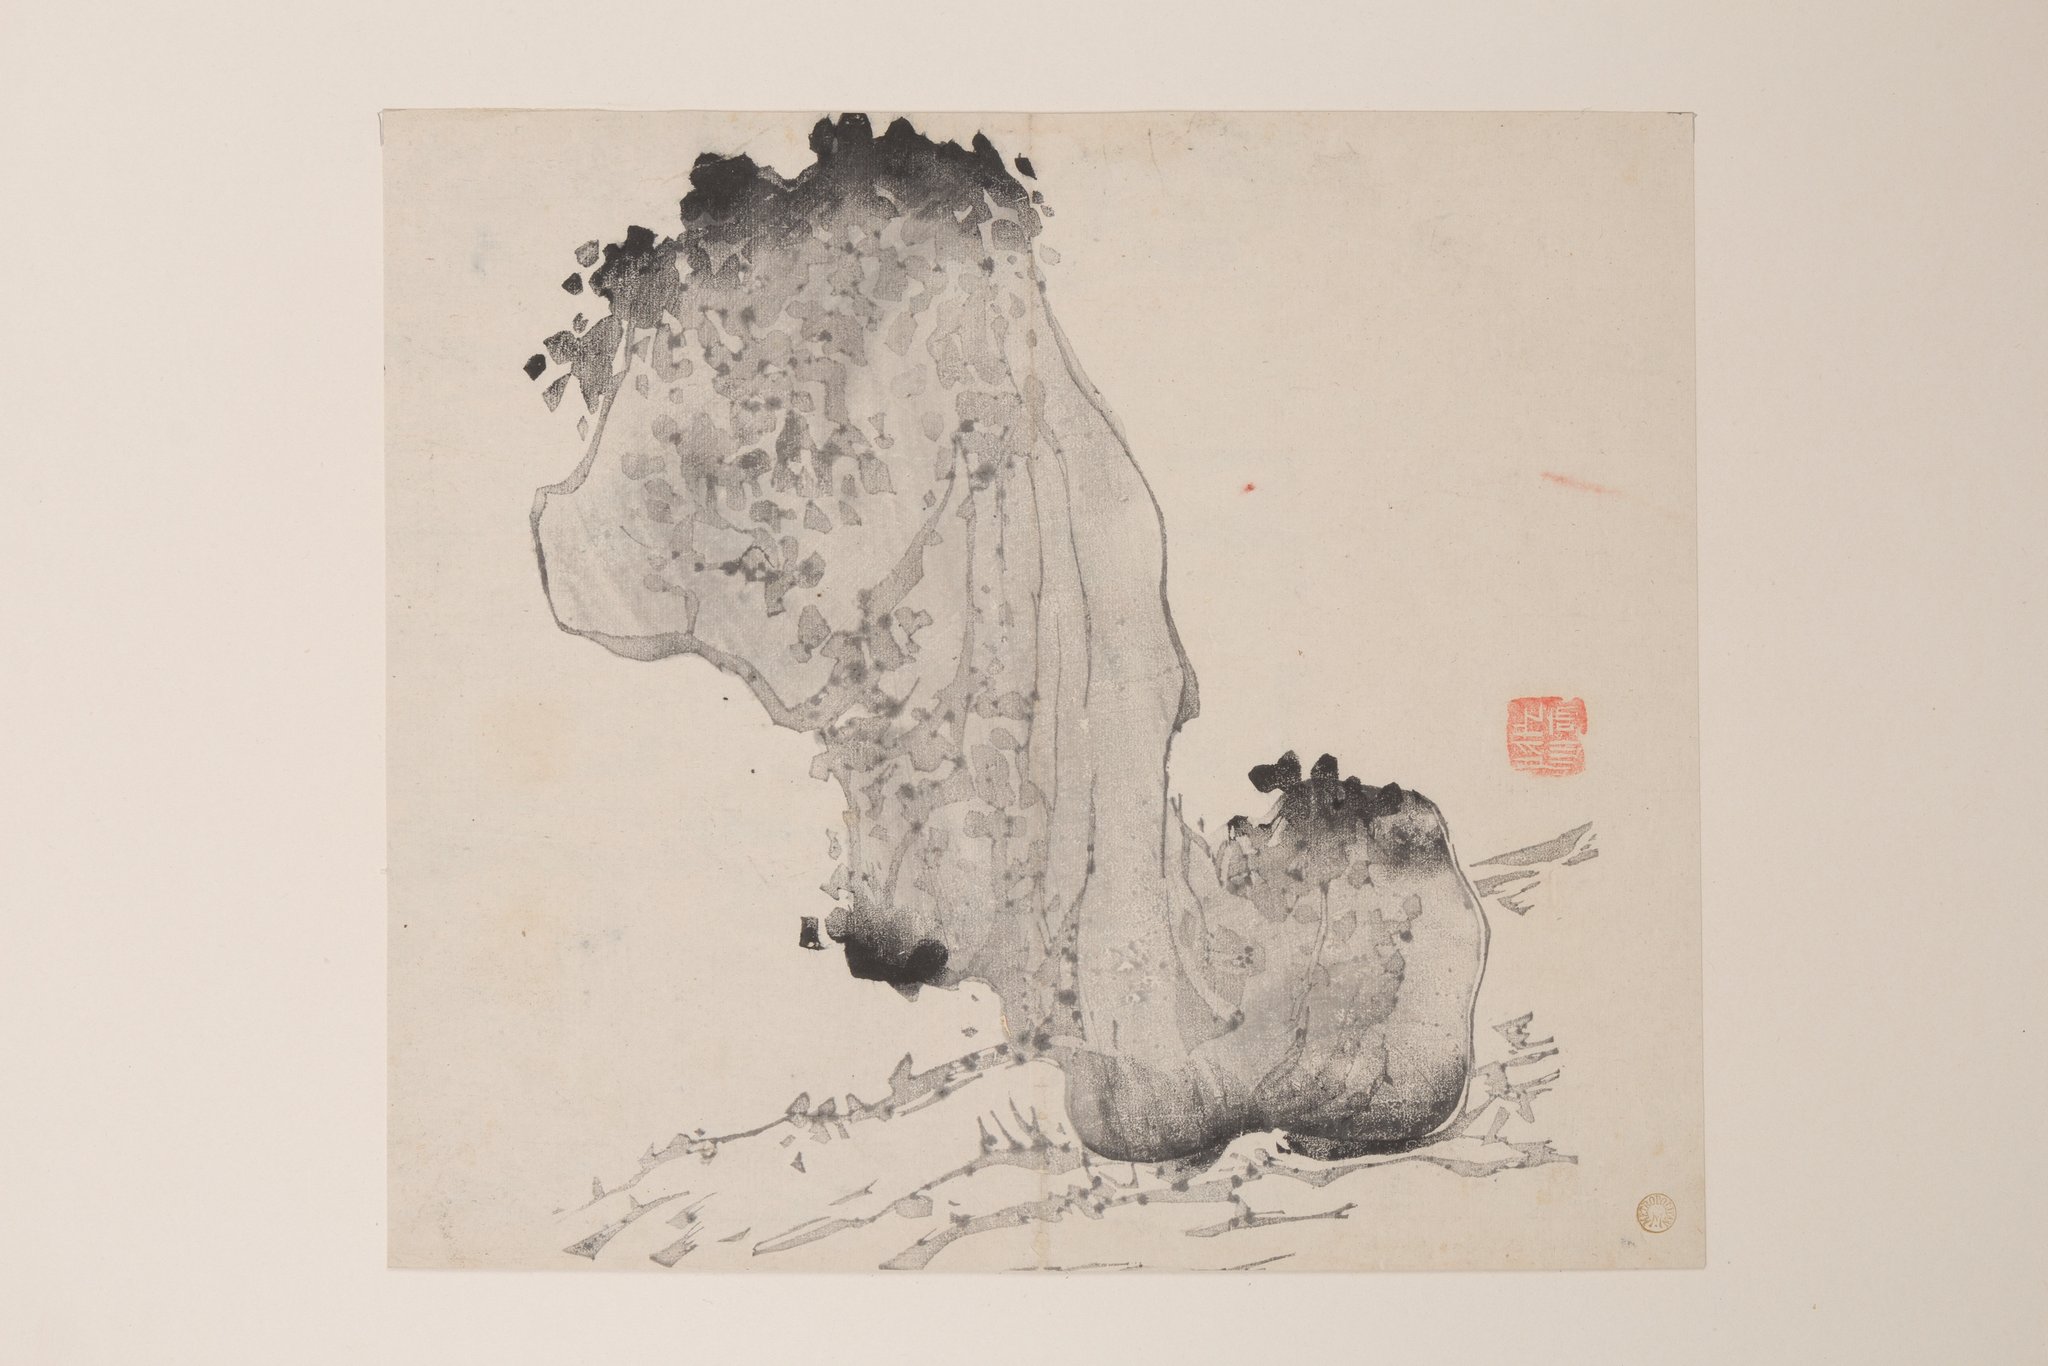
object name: print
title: Page from the Ten Bamboo Studio Manual of Painting and Calligraphy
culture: chinese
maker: hu zhengyan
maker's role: artist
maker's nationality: chinese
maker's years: 1584-1634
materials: ink, paper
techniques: printing